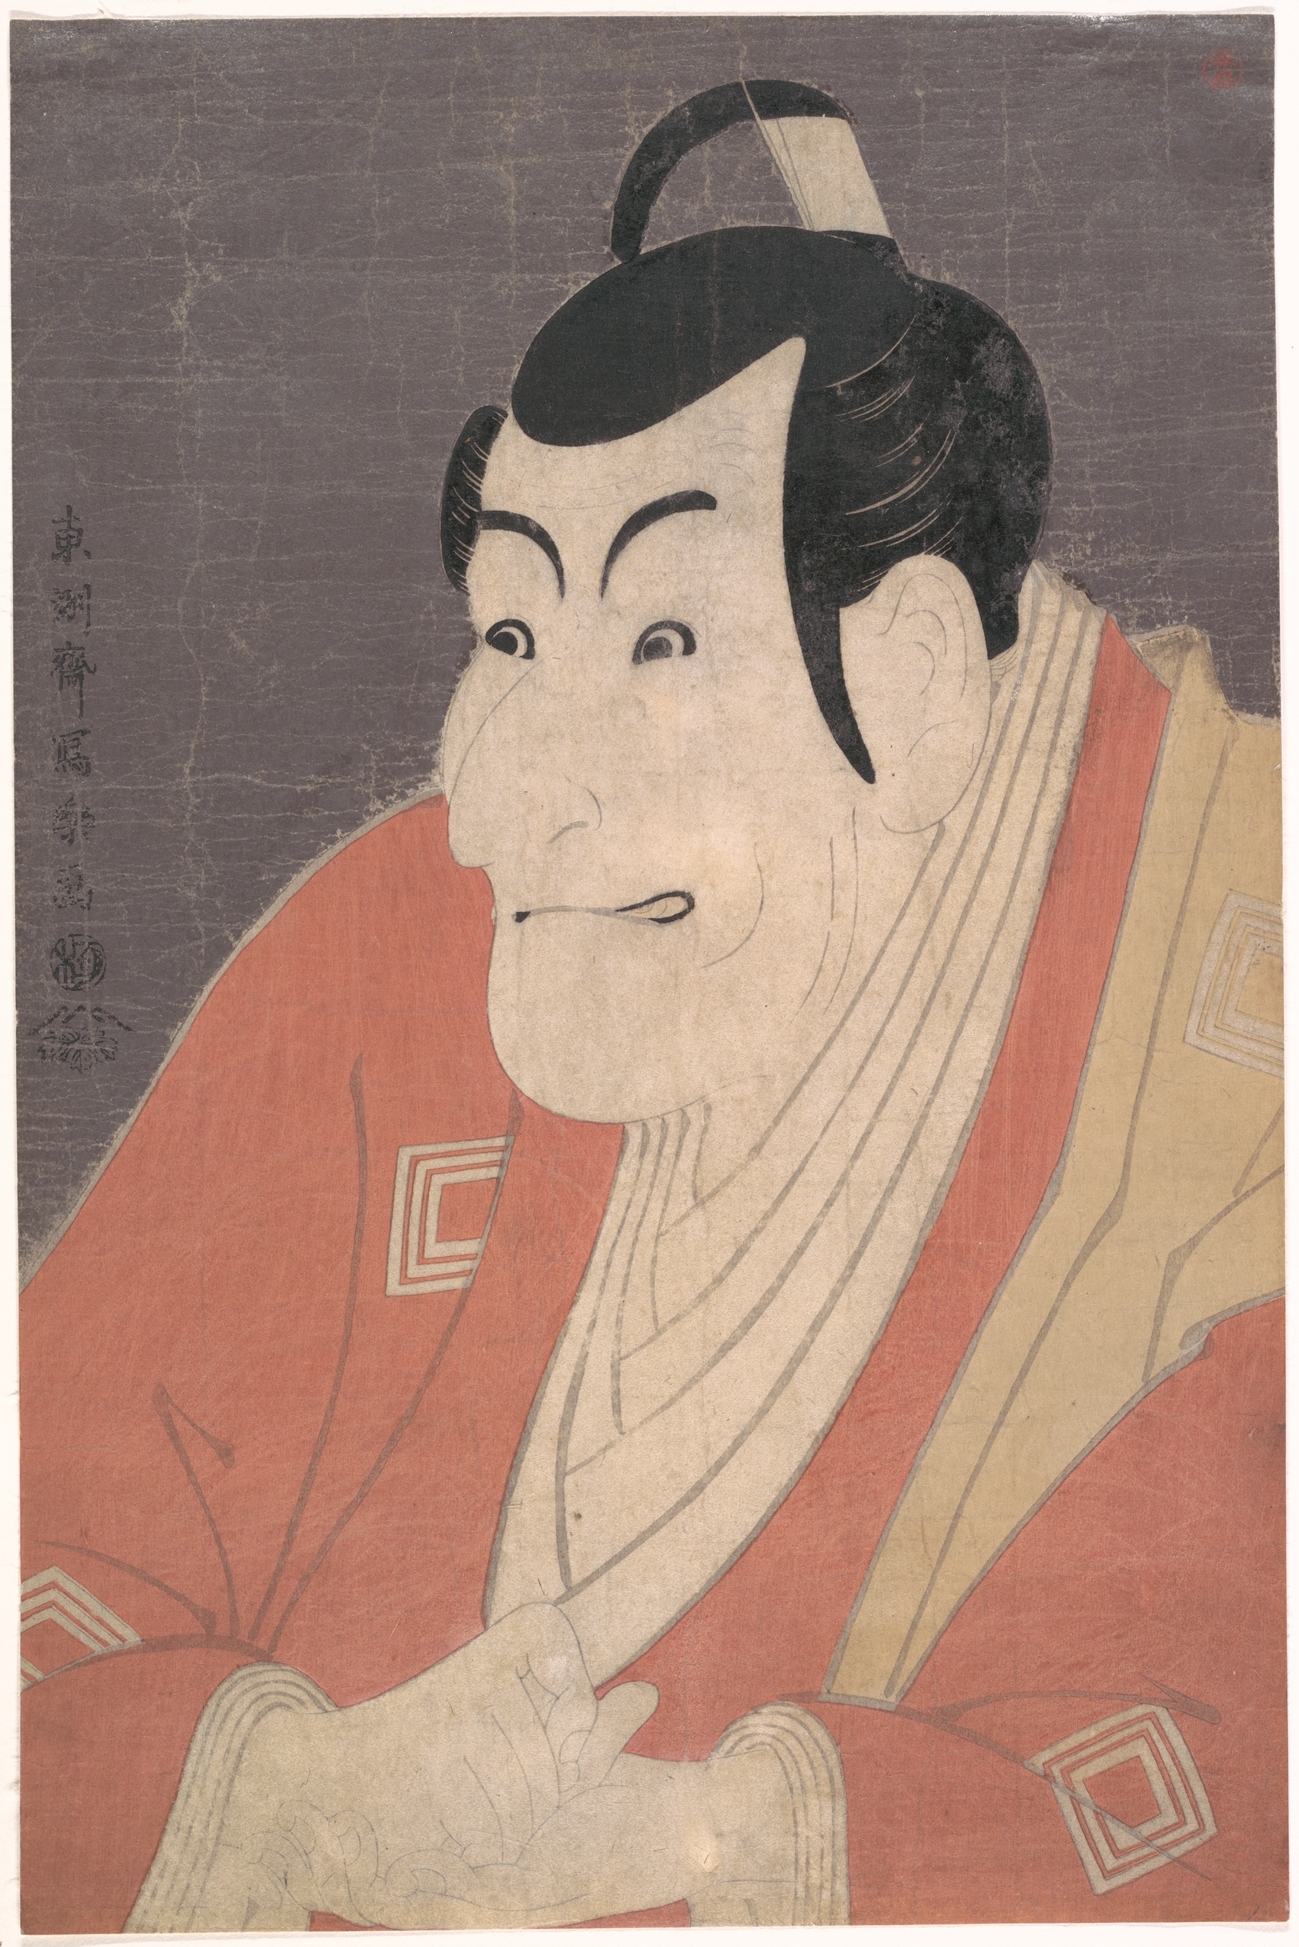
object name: print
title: Kabuki Actor Ichikawa Ebizō (Ichikawa Danjūrō V) in the play The Colored Reins of a Loving Wife (Koi nyōbō somewake tazuna)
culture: japanese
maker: tōshūsai sharaku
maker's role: artist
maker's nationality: japanese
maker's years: 1794-1795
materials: ink, mica, paper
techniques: woodblock print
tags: men,actors